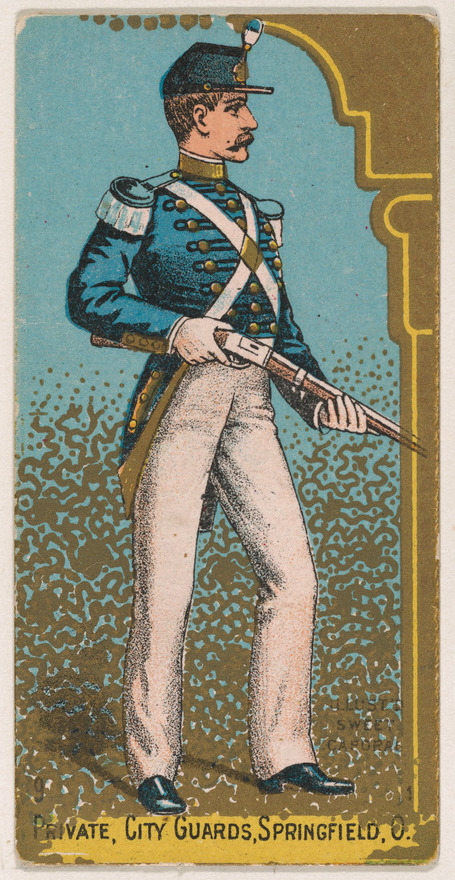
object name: print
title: Private, City Guards, Springfield, Ohio, from the Military Series (N224) issued by Kinney Tobacco Company to promote Sweet Caporal Cigarettes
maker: kinney brothers tobacco company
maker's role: publisher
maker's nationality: american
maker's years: 1869-2011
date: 1888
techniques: color lithograph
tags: military,men,profiles